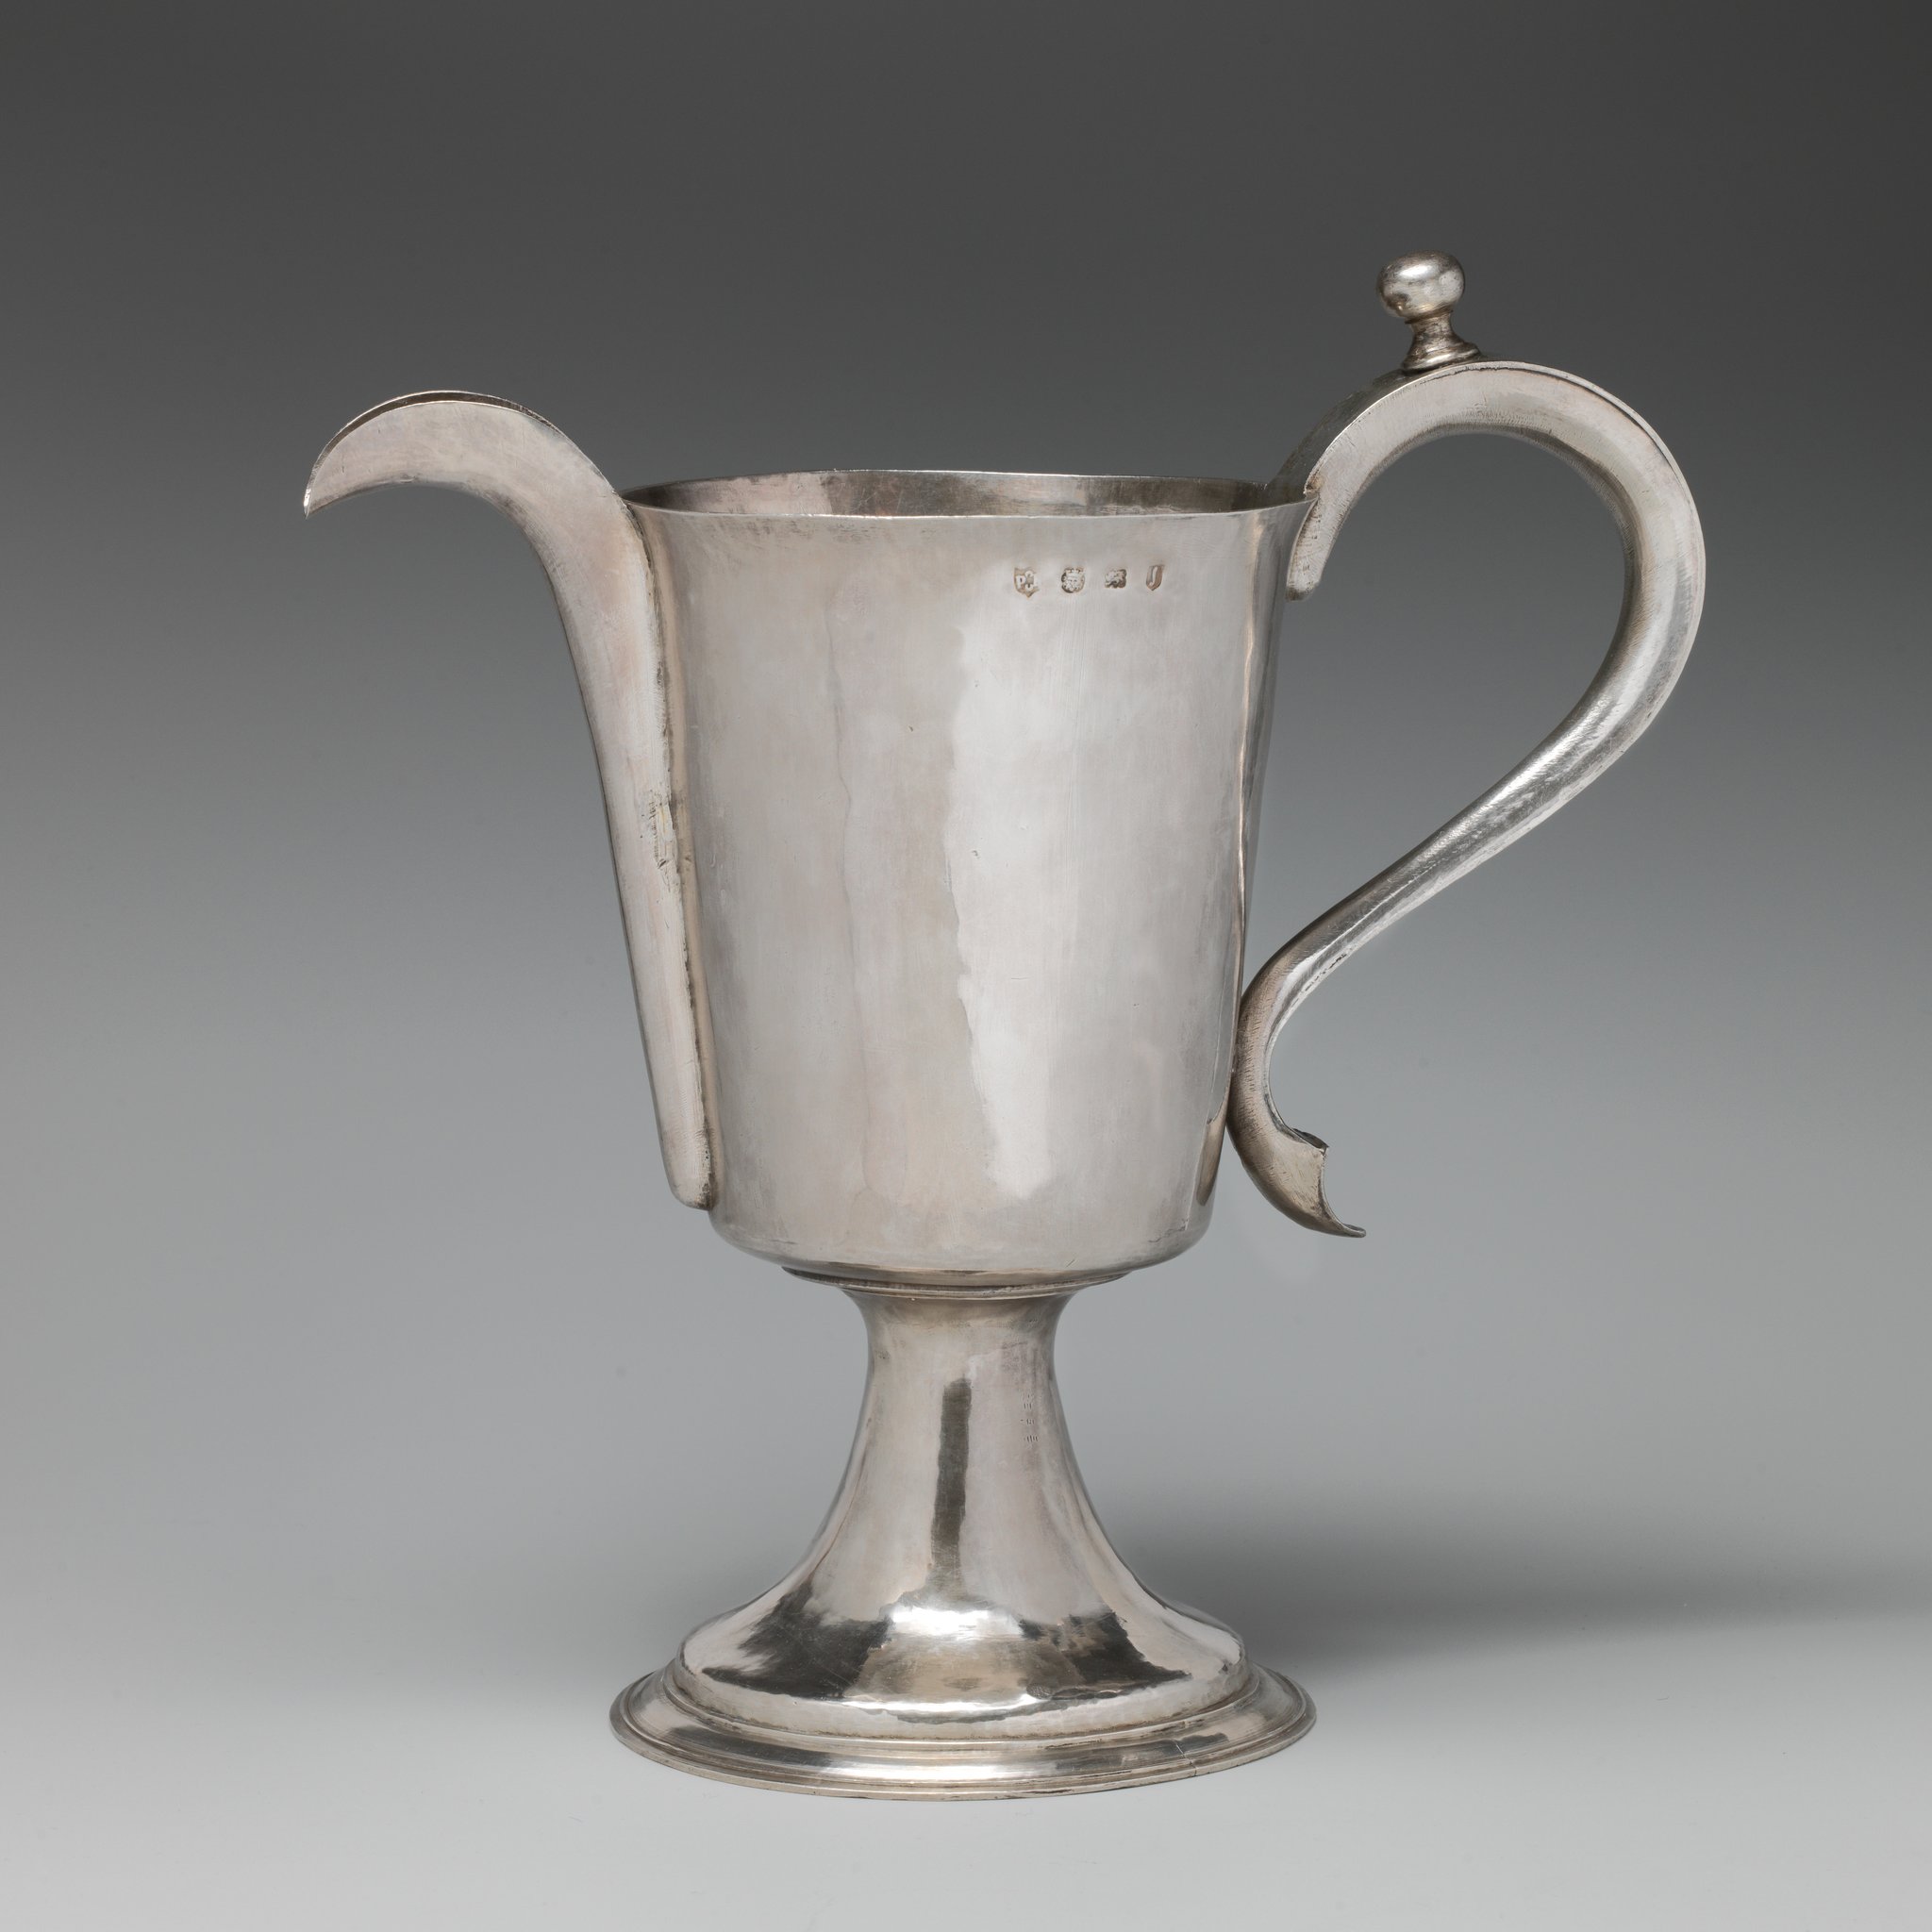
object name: ewer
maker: peter bettesworth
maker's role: maker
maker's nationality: british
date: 1635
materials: silver